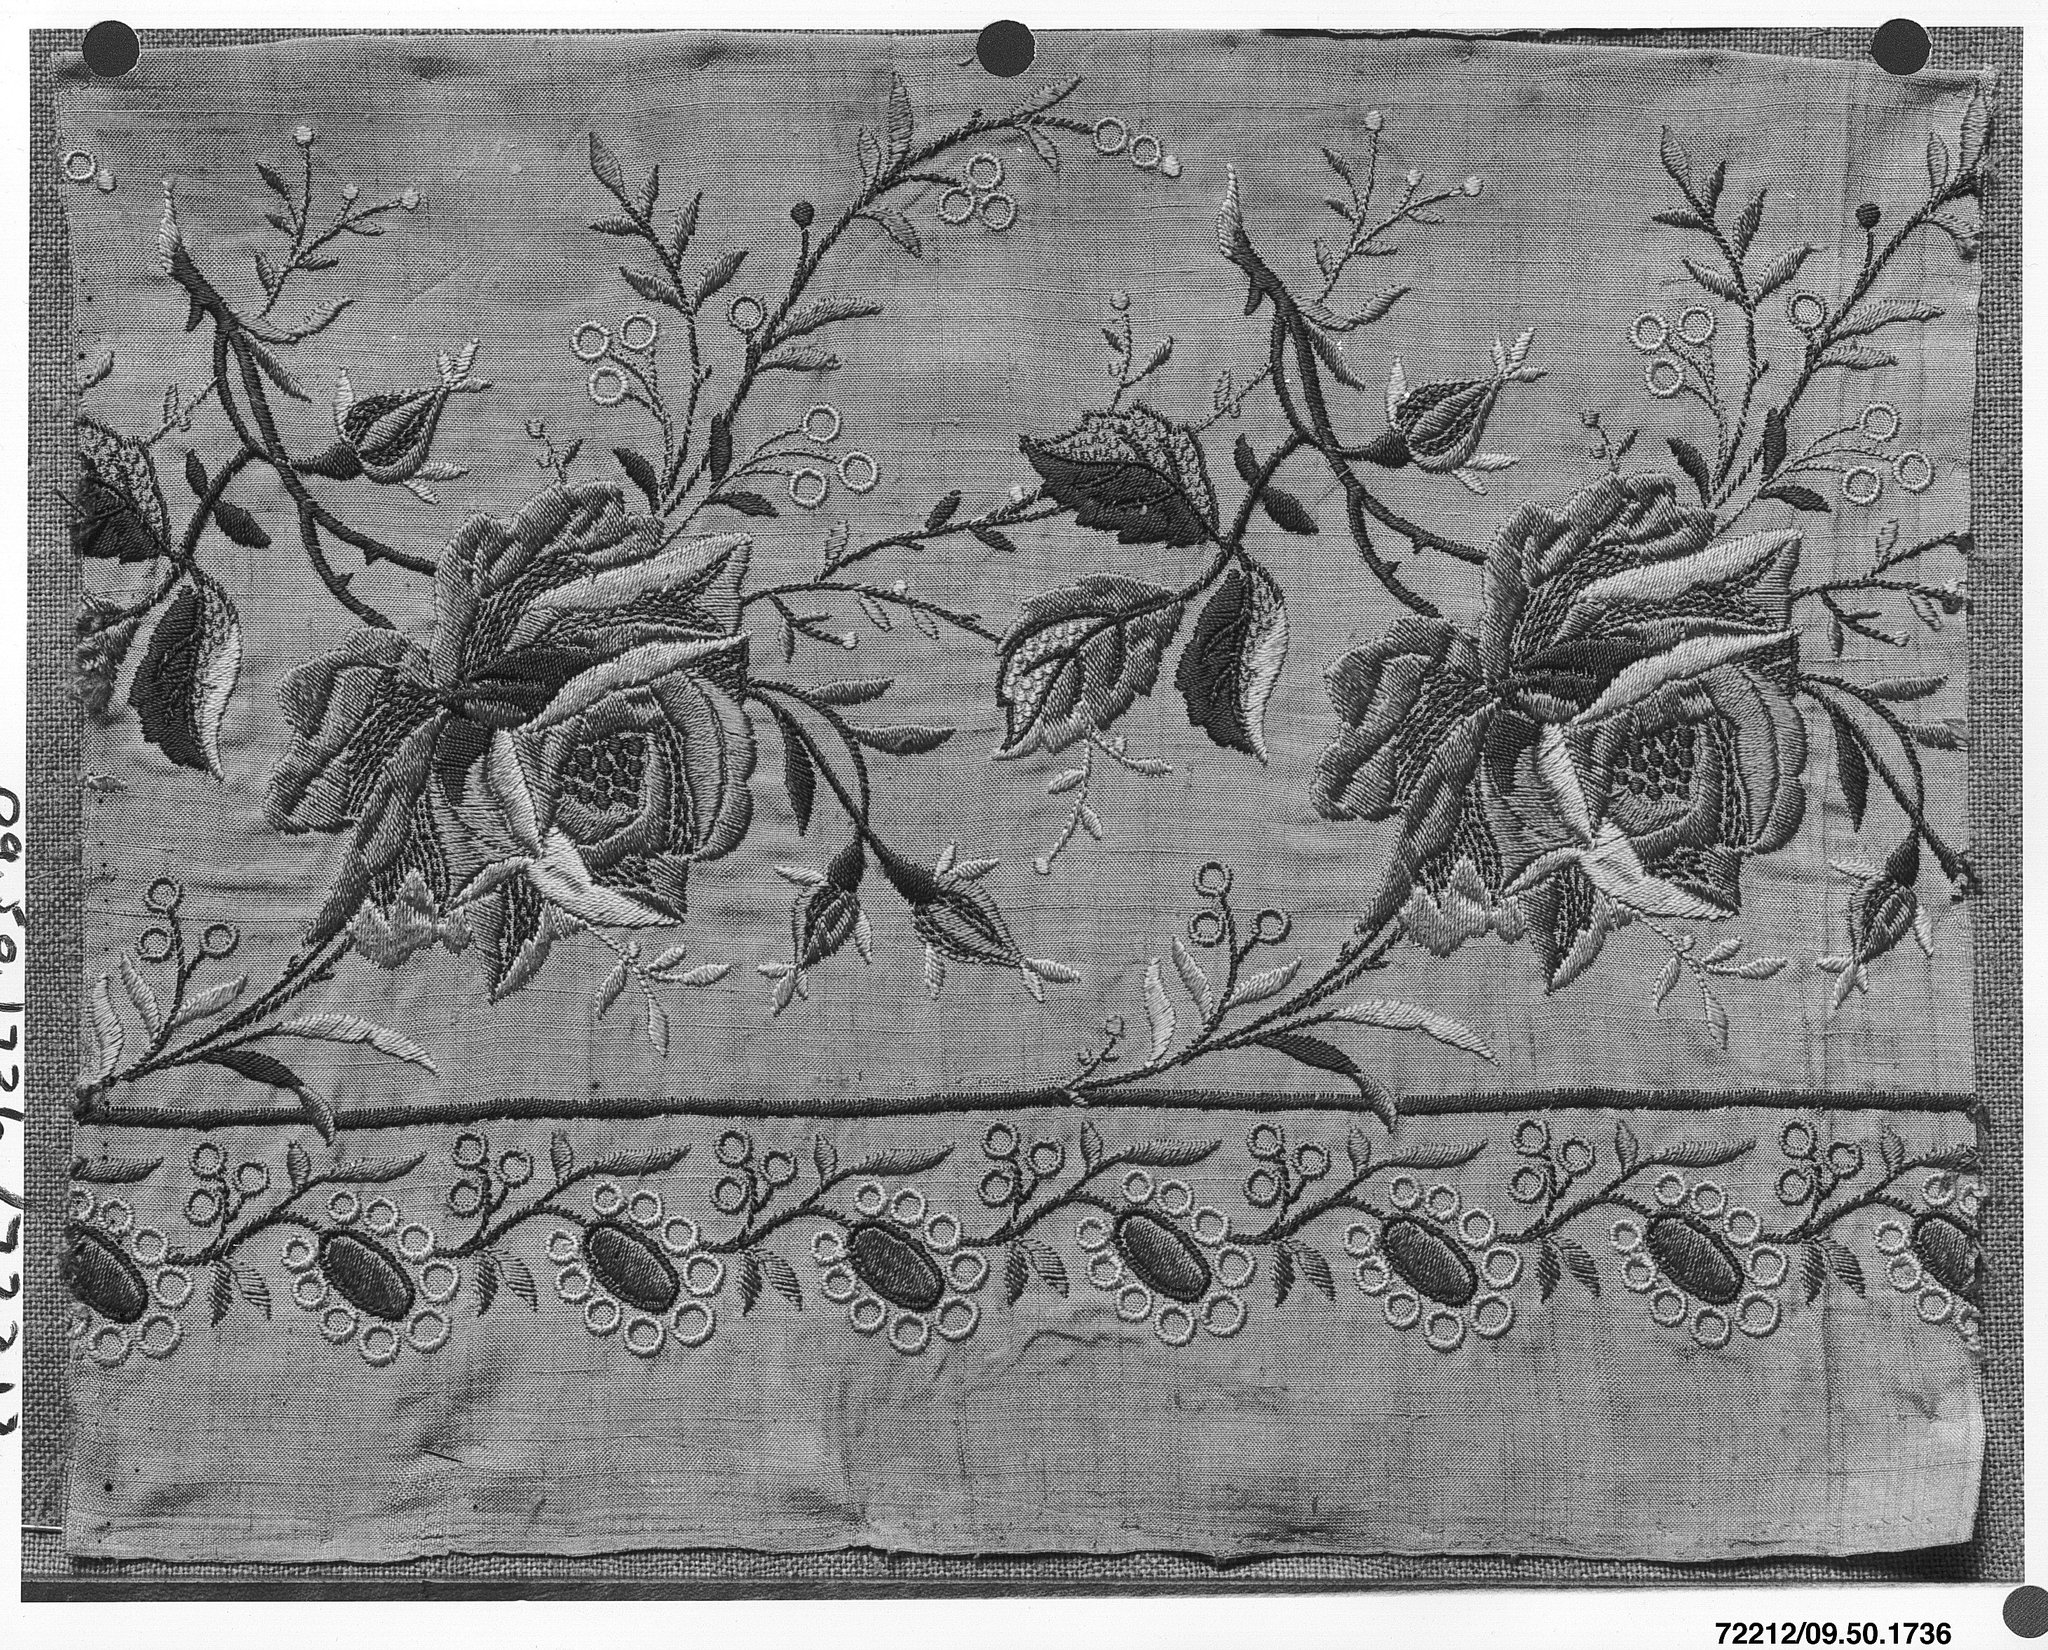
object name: fragment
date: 1801-1900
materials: silk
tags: roses,leaves